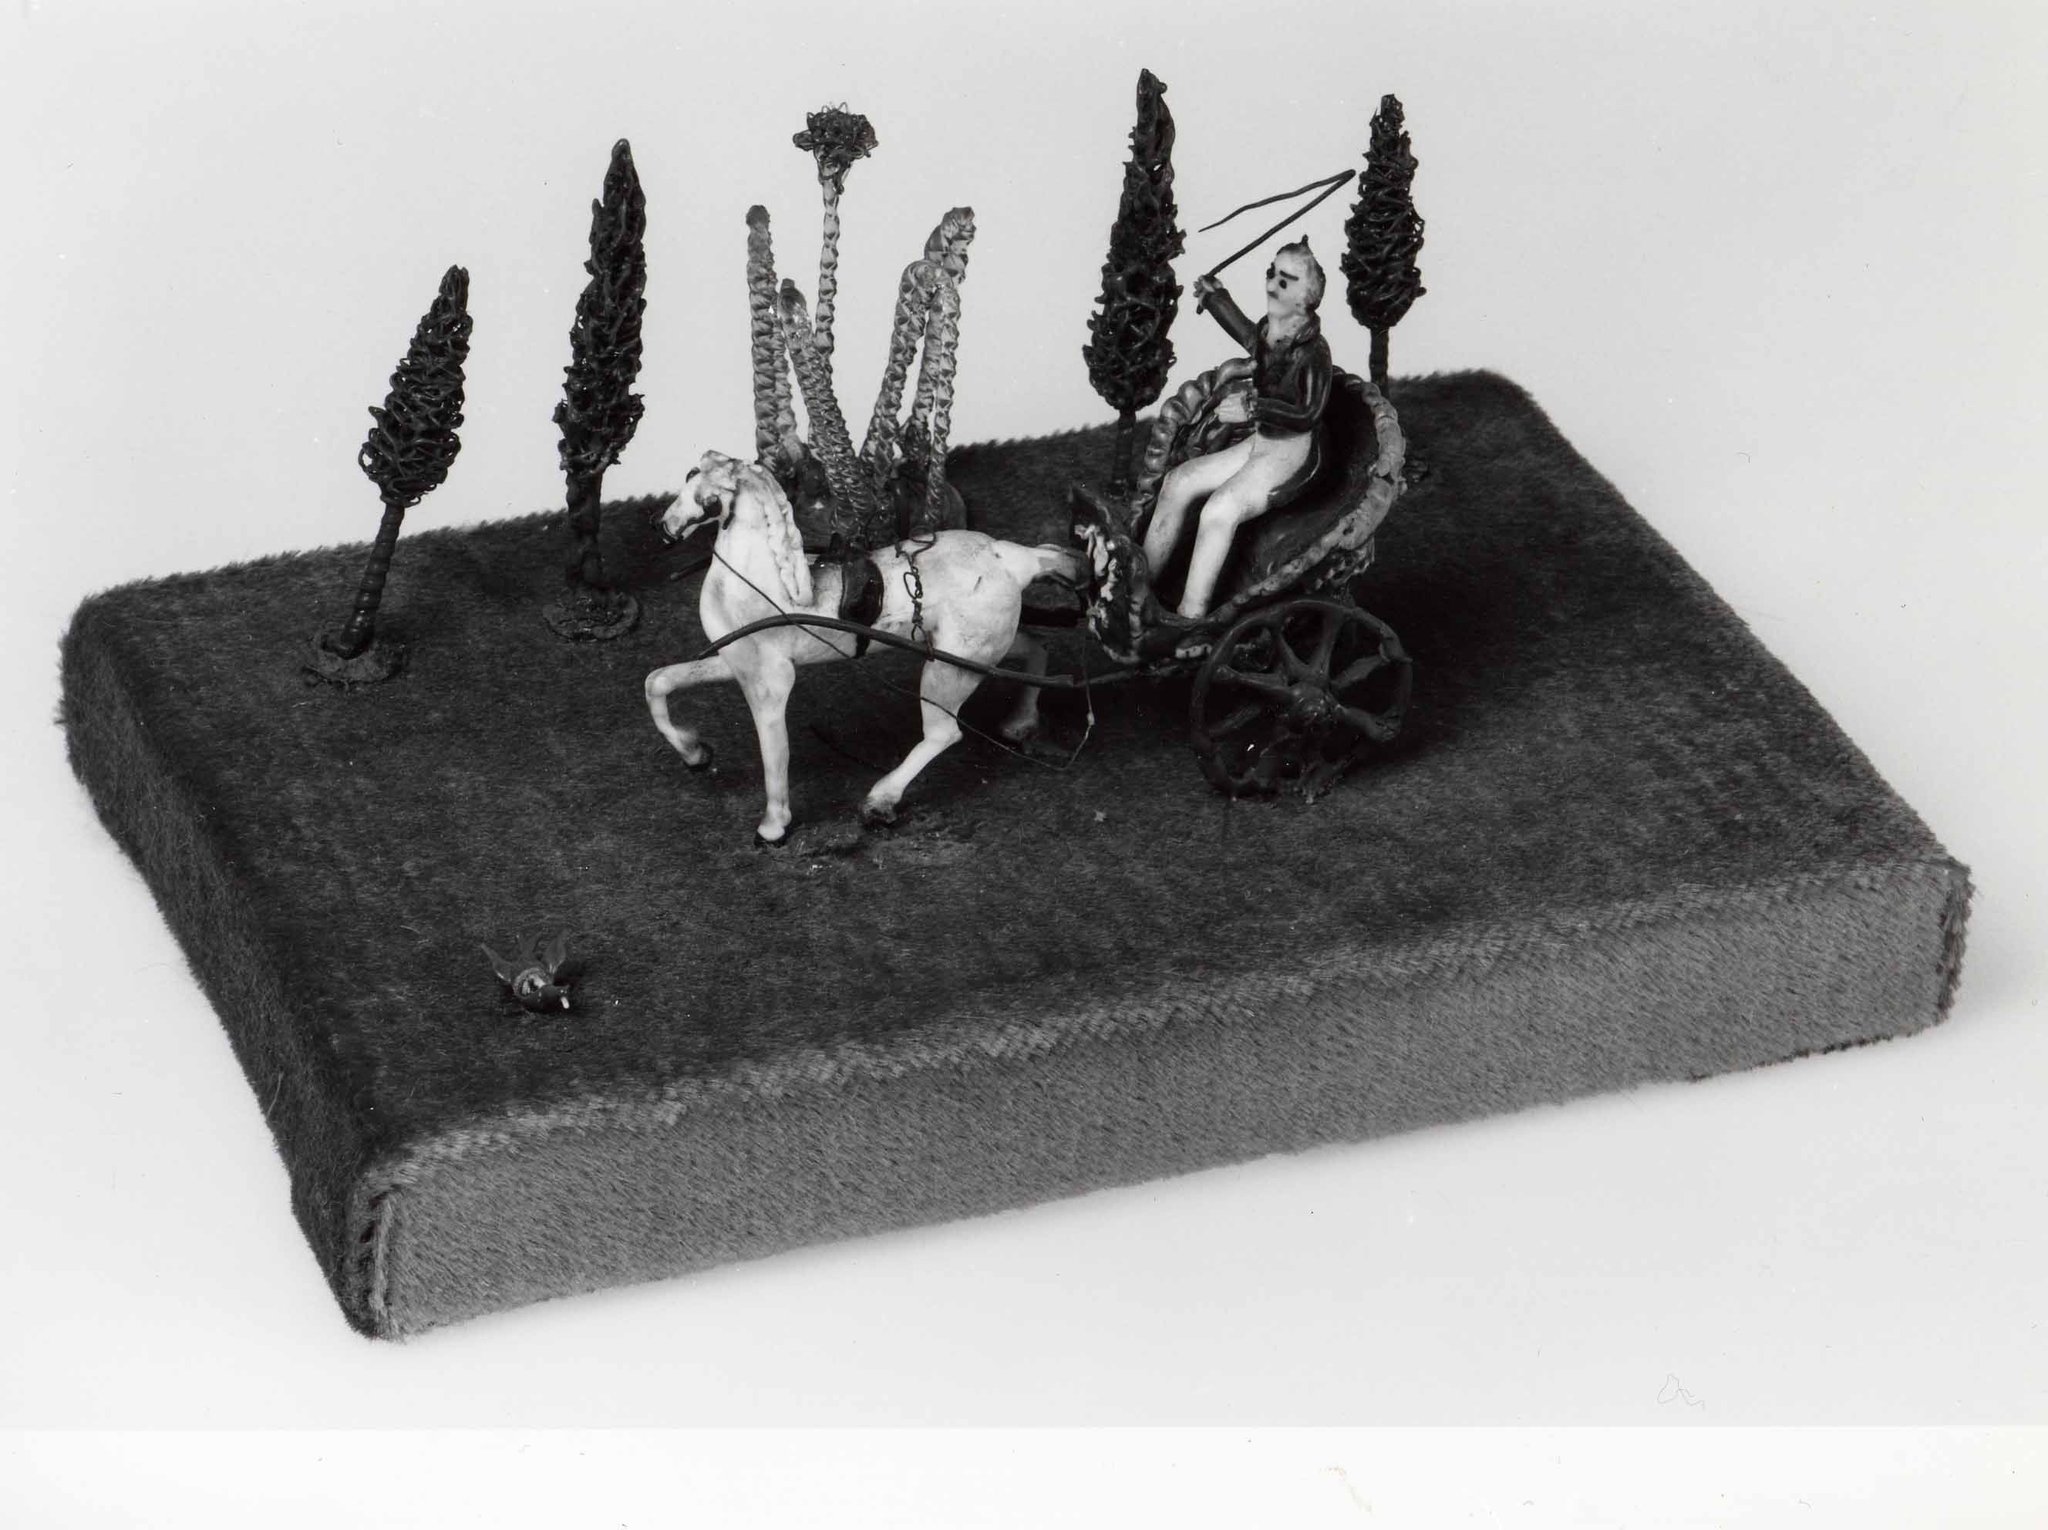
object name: figurine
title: Cabriolet with Driver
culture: french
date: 1834-1866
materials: glass, iron, metal, wood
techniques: lampwork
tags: men,horses,carriages